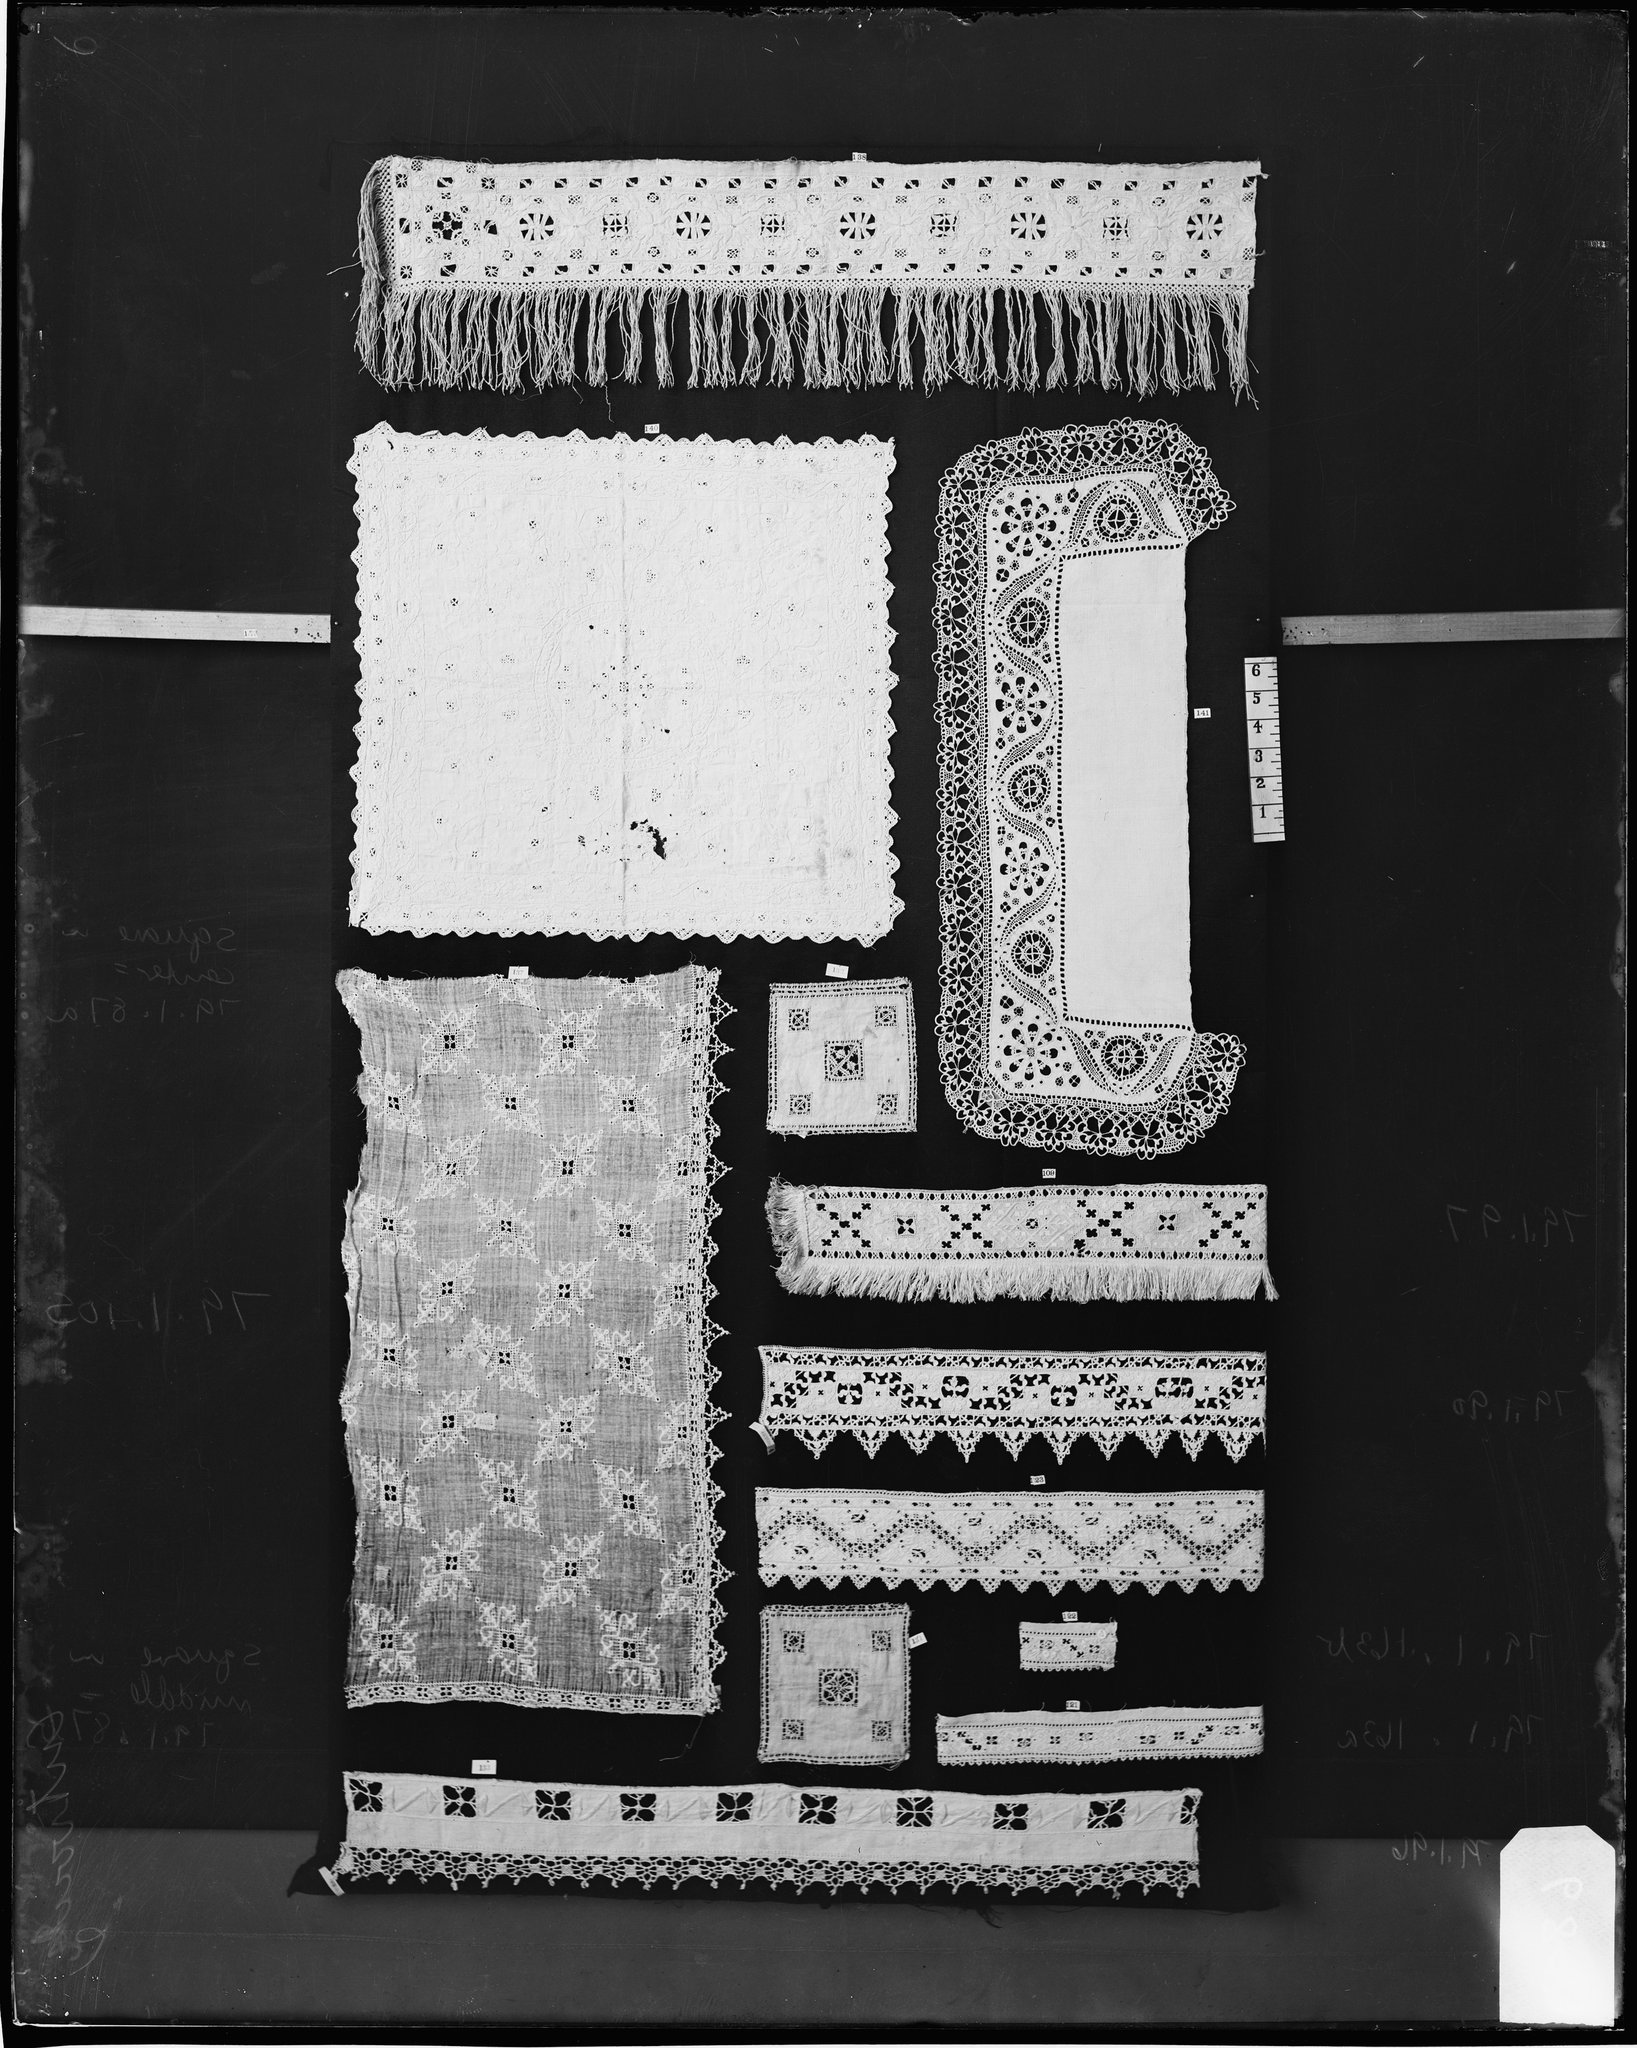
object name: border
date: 1501-1600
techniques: embroidery